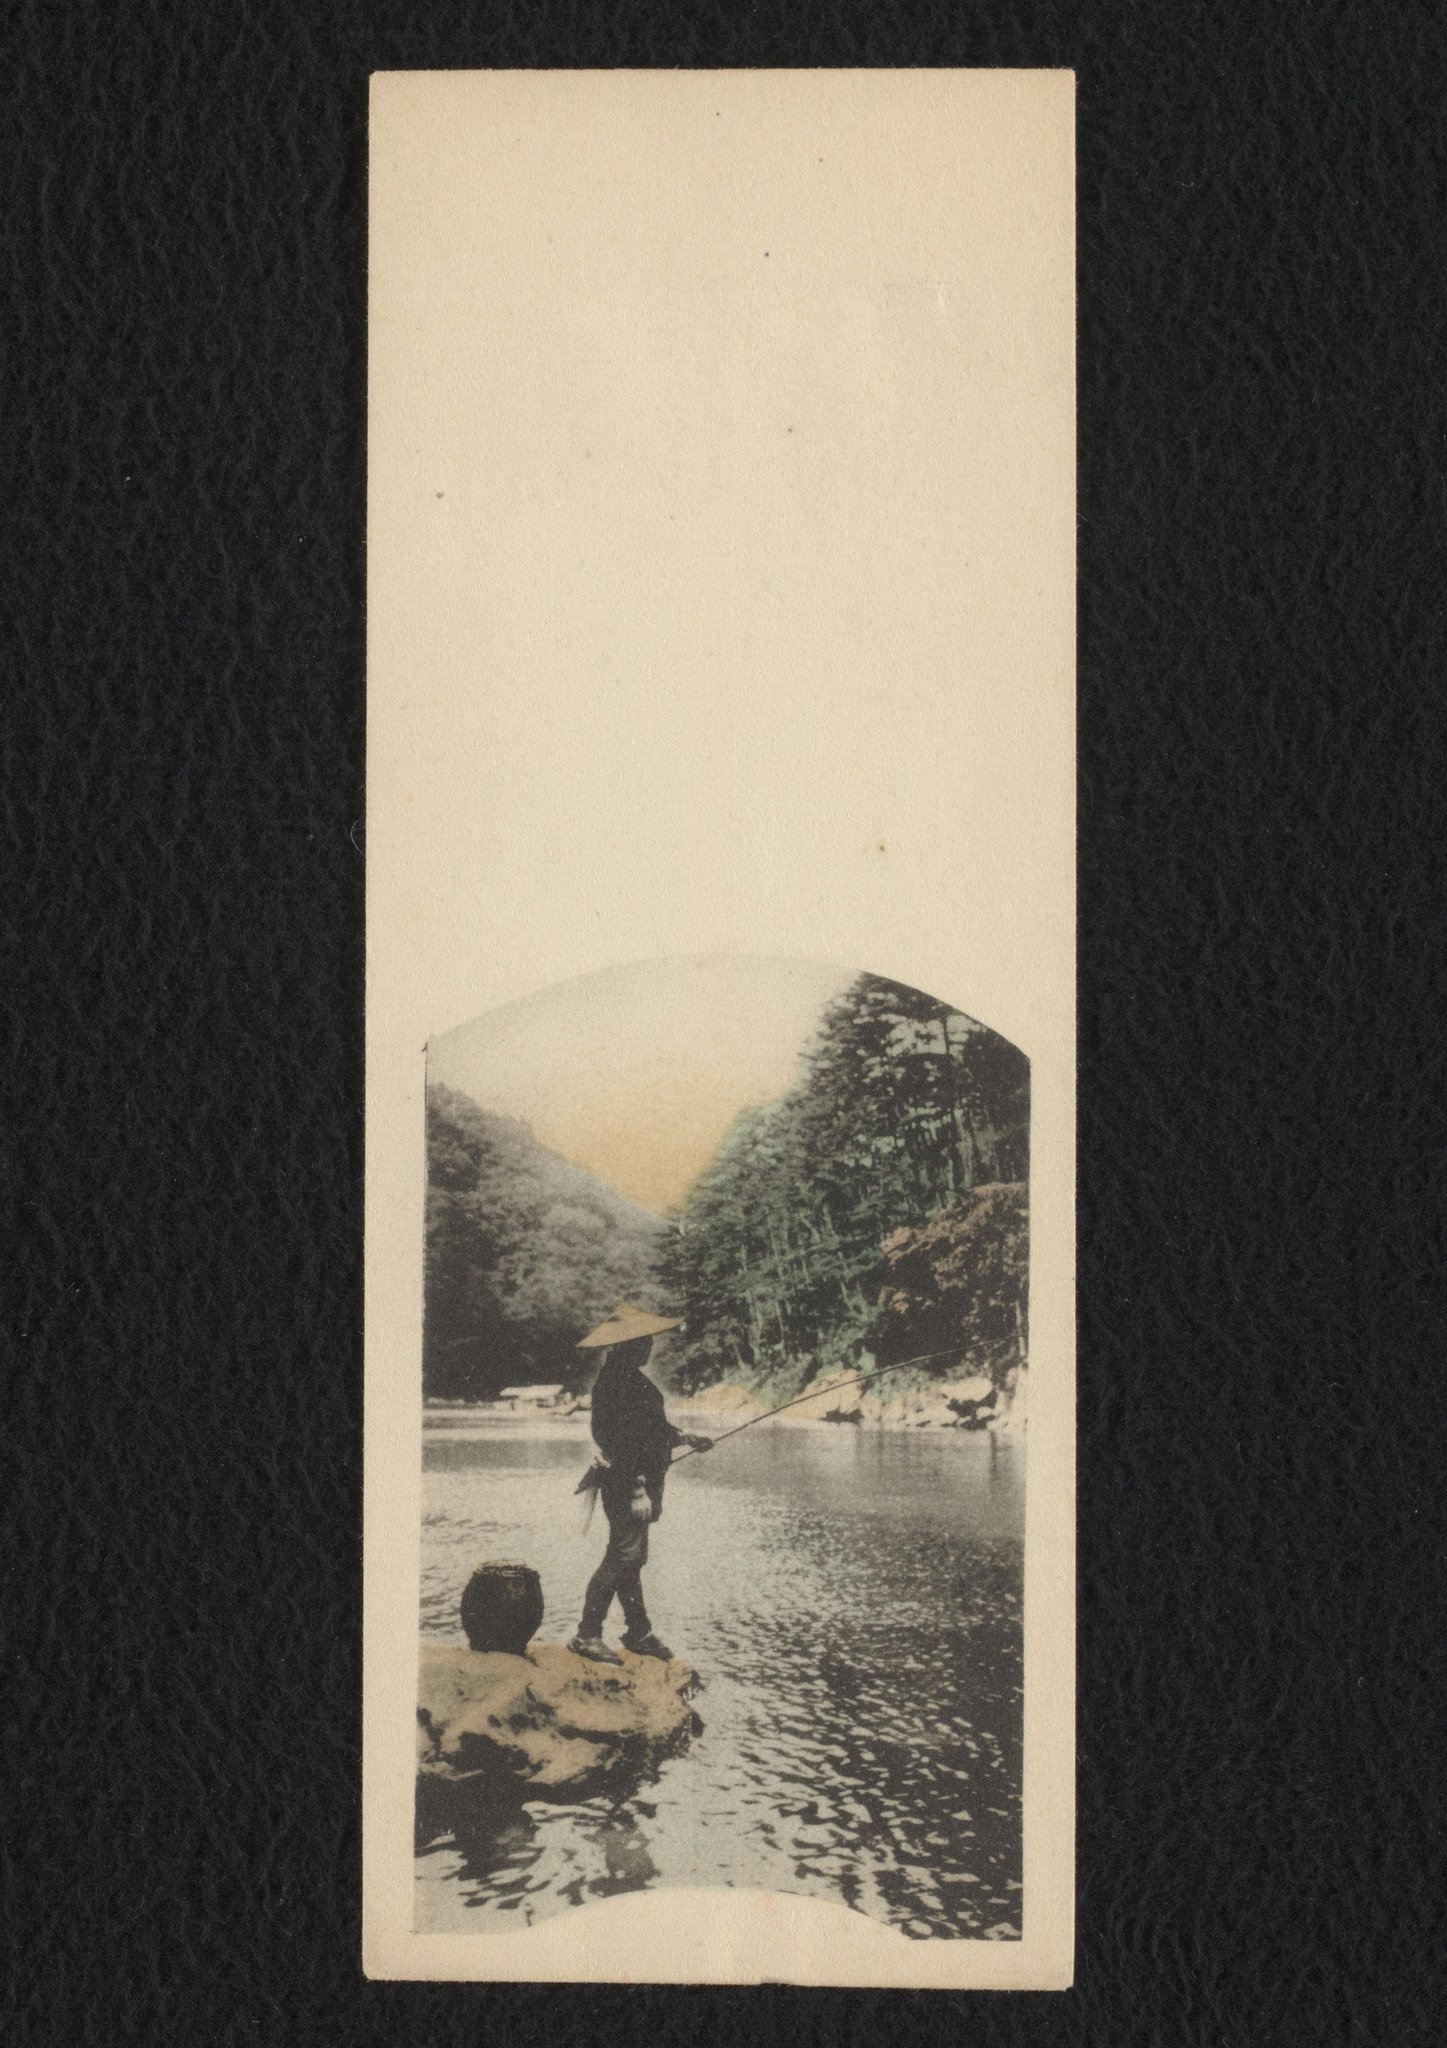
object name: photomechanical print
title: Staande vissende man aan een waterkant in Japan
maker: Anonymous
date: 1890-1920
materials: paper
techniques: photograph, lithograph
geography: japan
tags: fisherman, japan